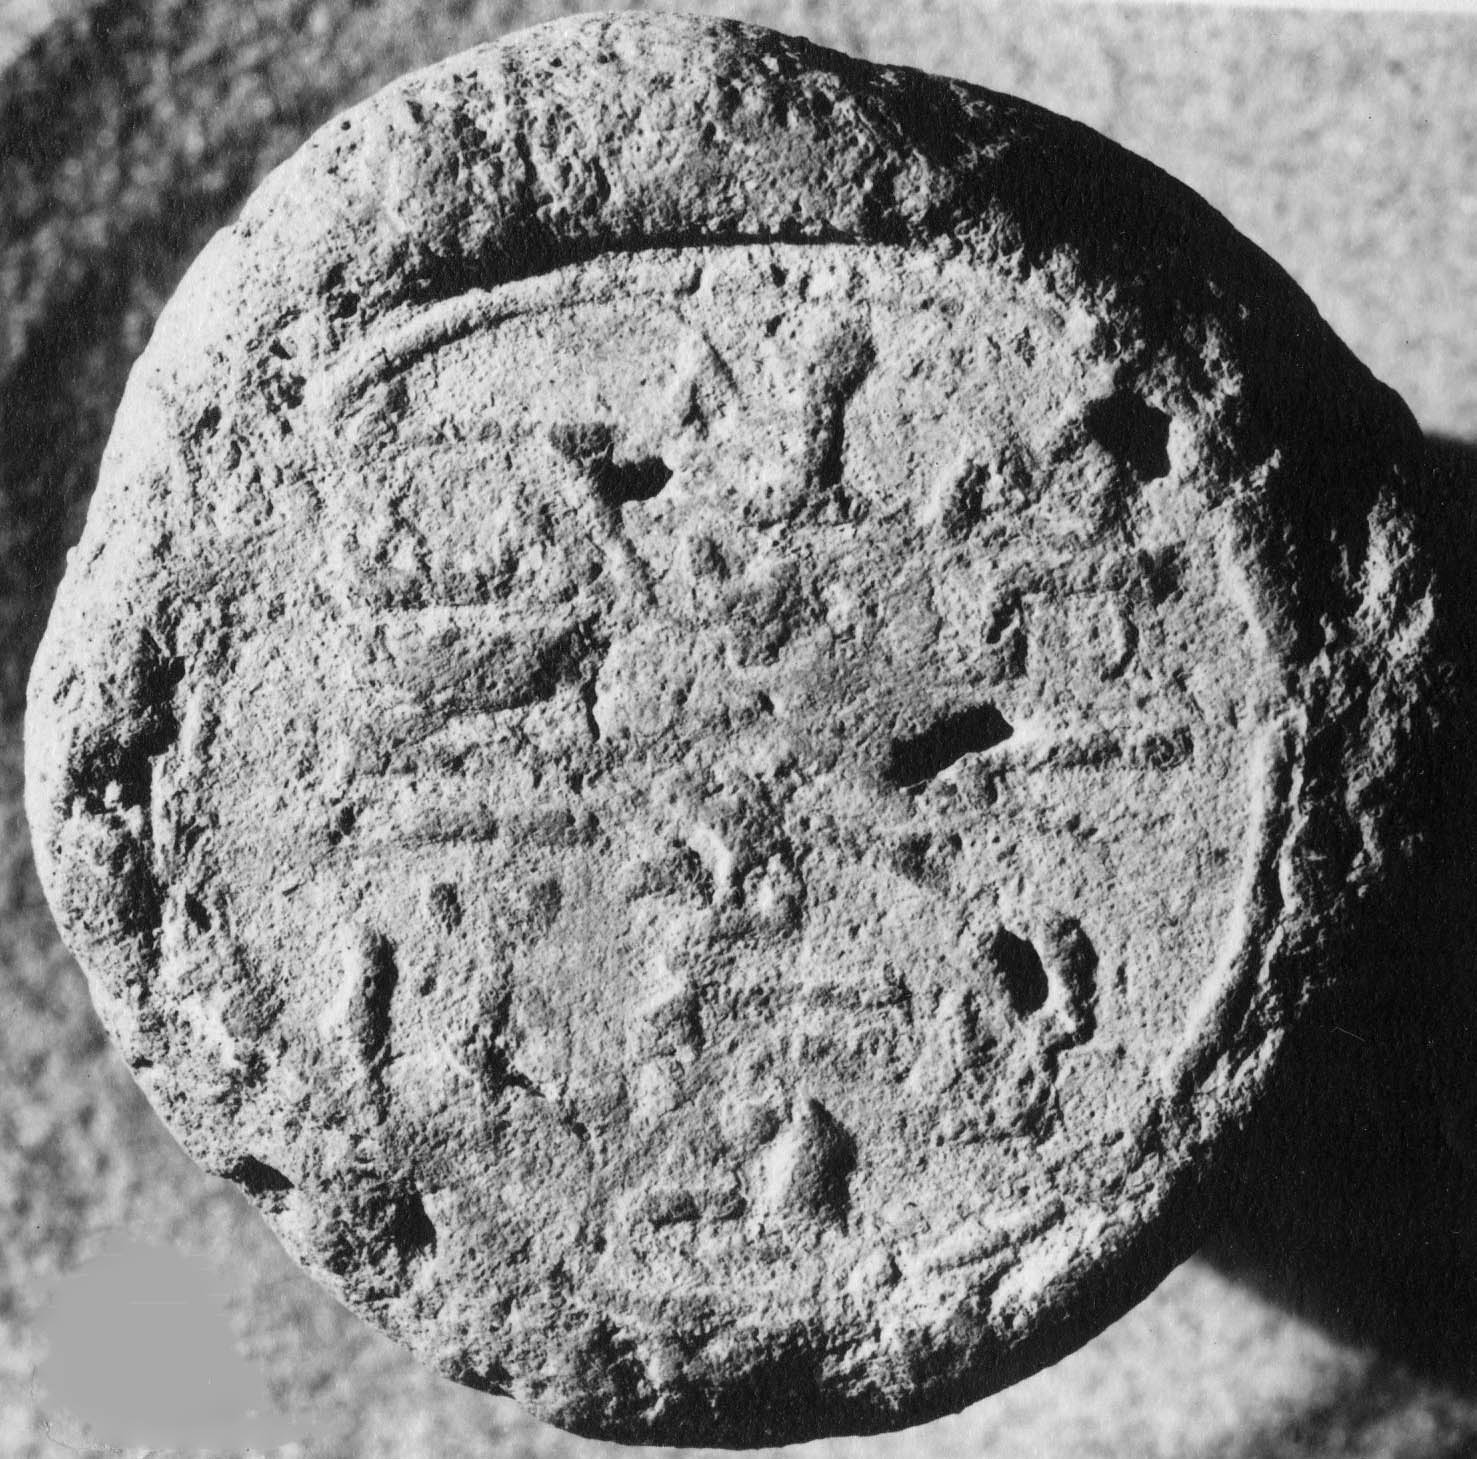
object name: cone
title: Funerary Cone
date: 1550-1295 BCE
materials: pottery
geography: egypt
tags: hieroglyphs